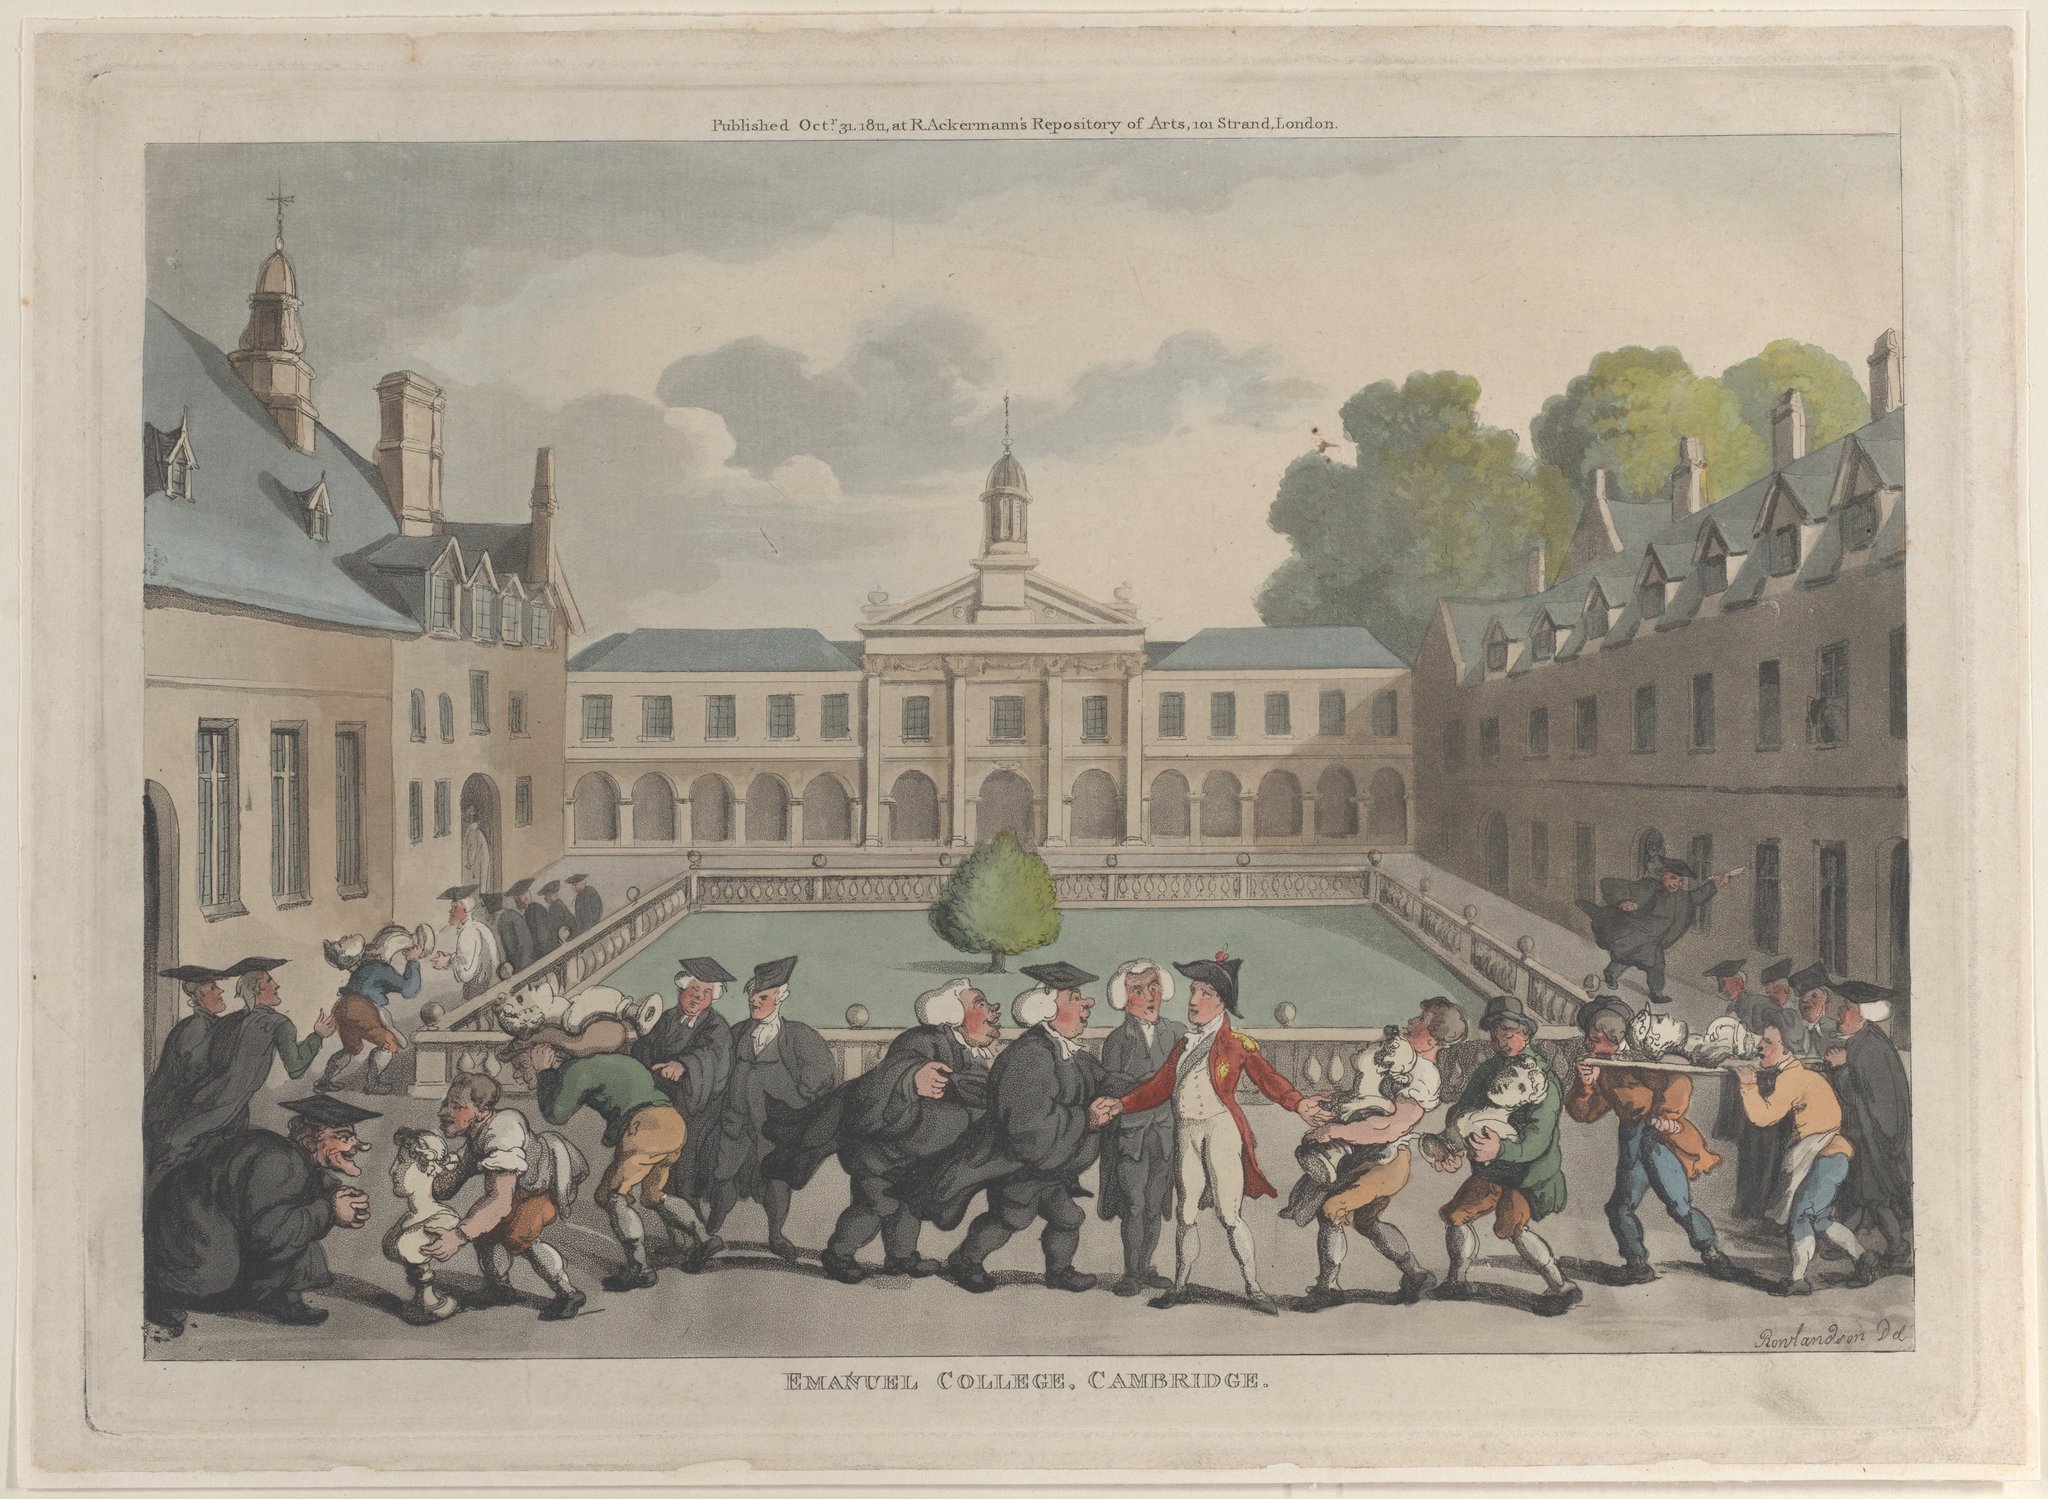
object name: print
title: Emanuel College, Cambridge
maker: thomas rowlandson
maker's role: artist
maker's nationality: british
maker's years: 1757-1827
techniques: aquatint, etching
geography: london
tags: schools,men